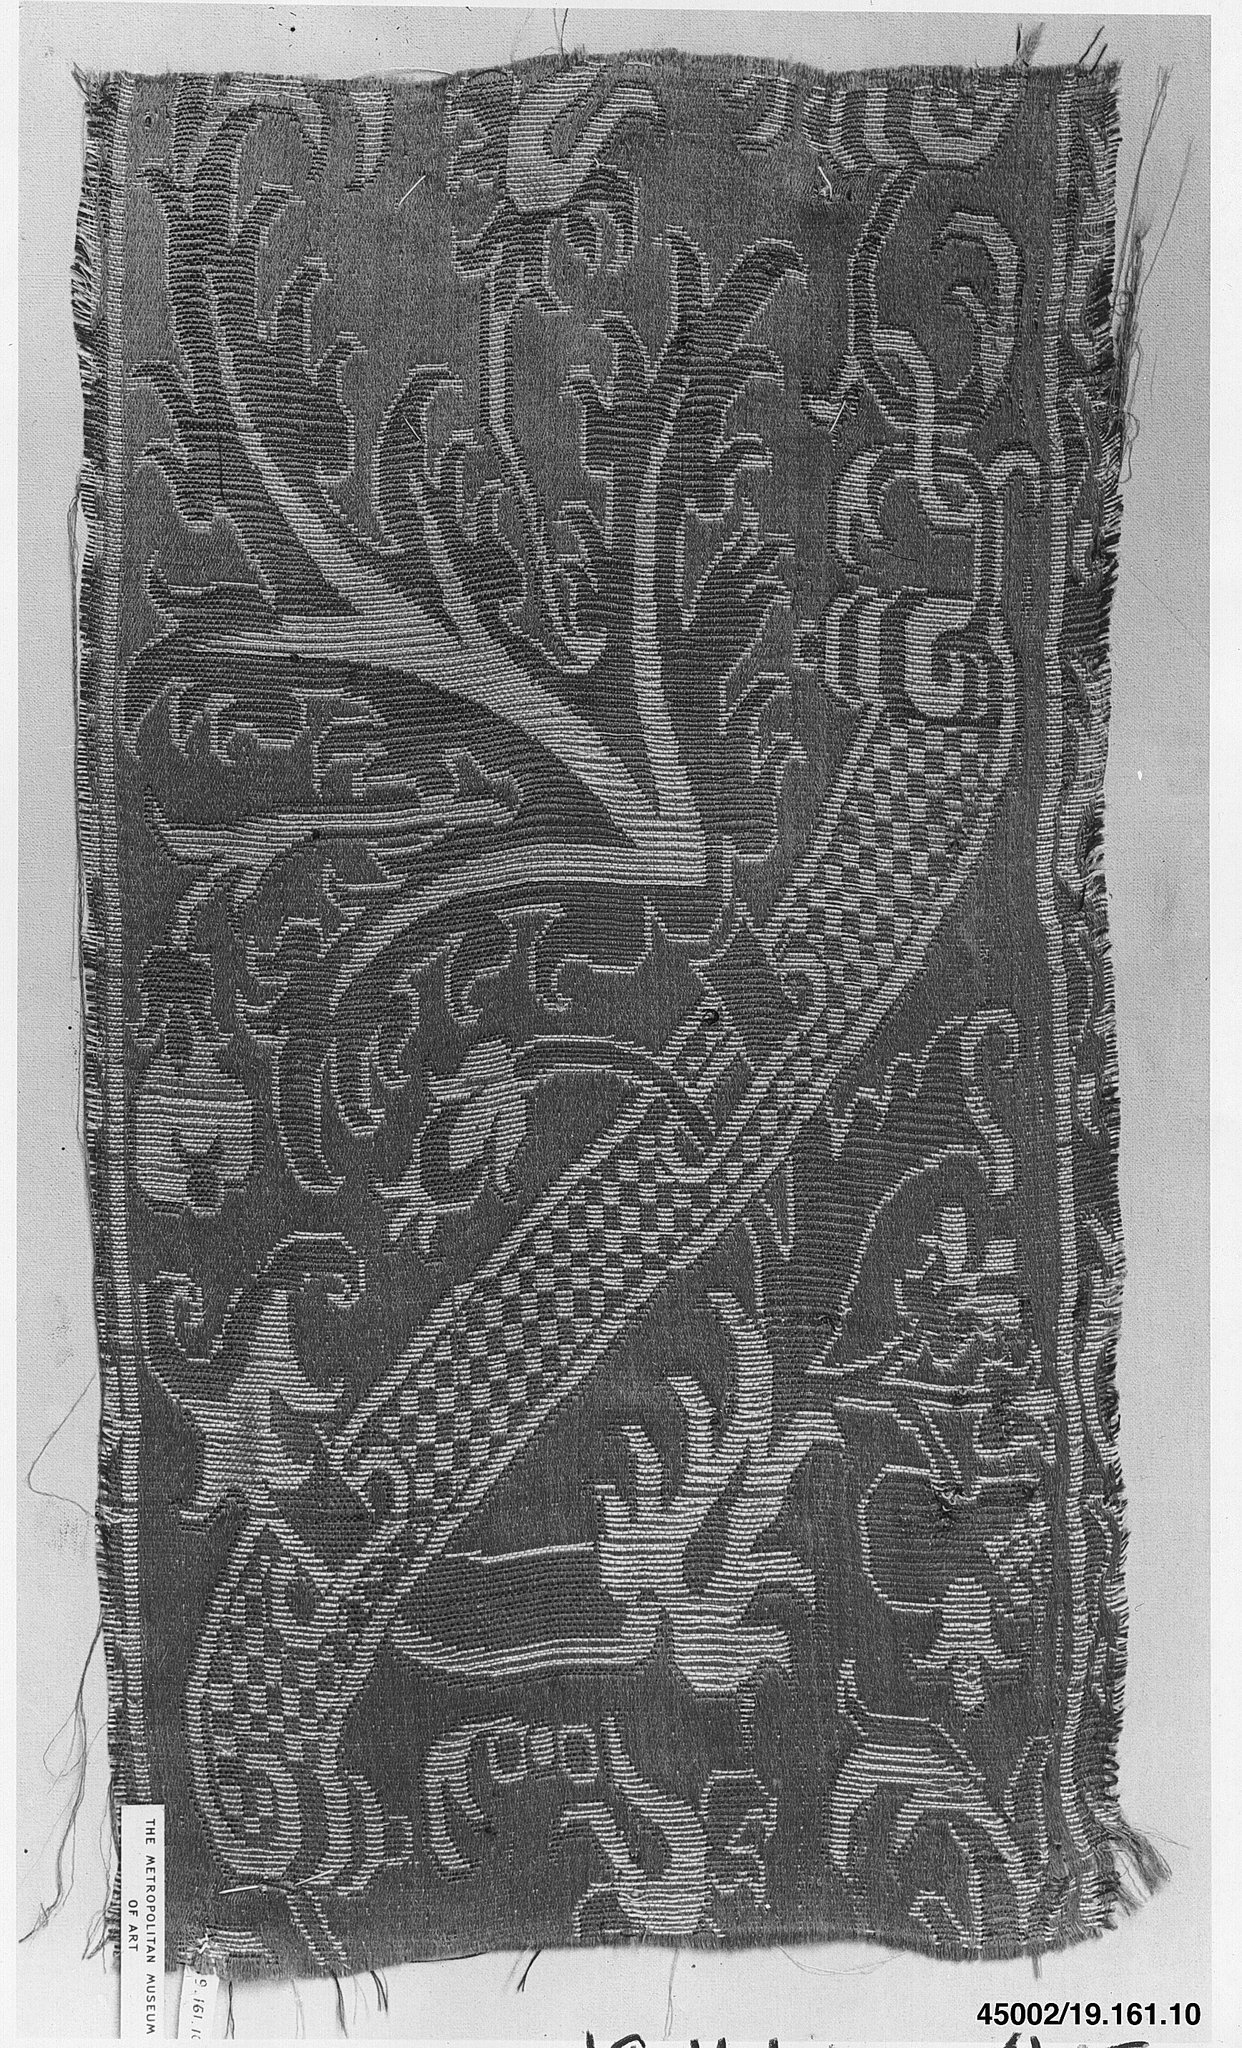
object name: fragment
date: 1601-1700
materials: silk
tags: leaves